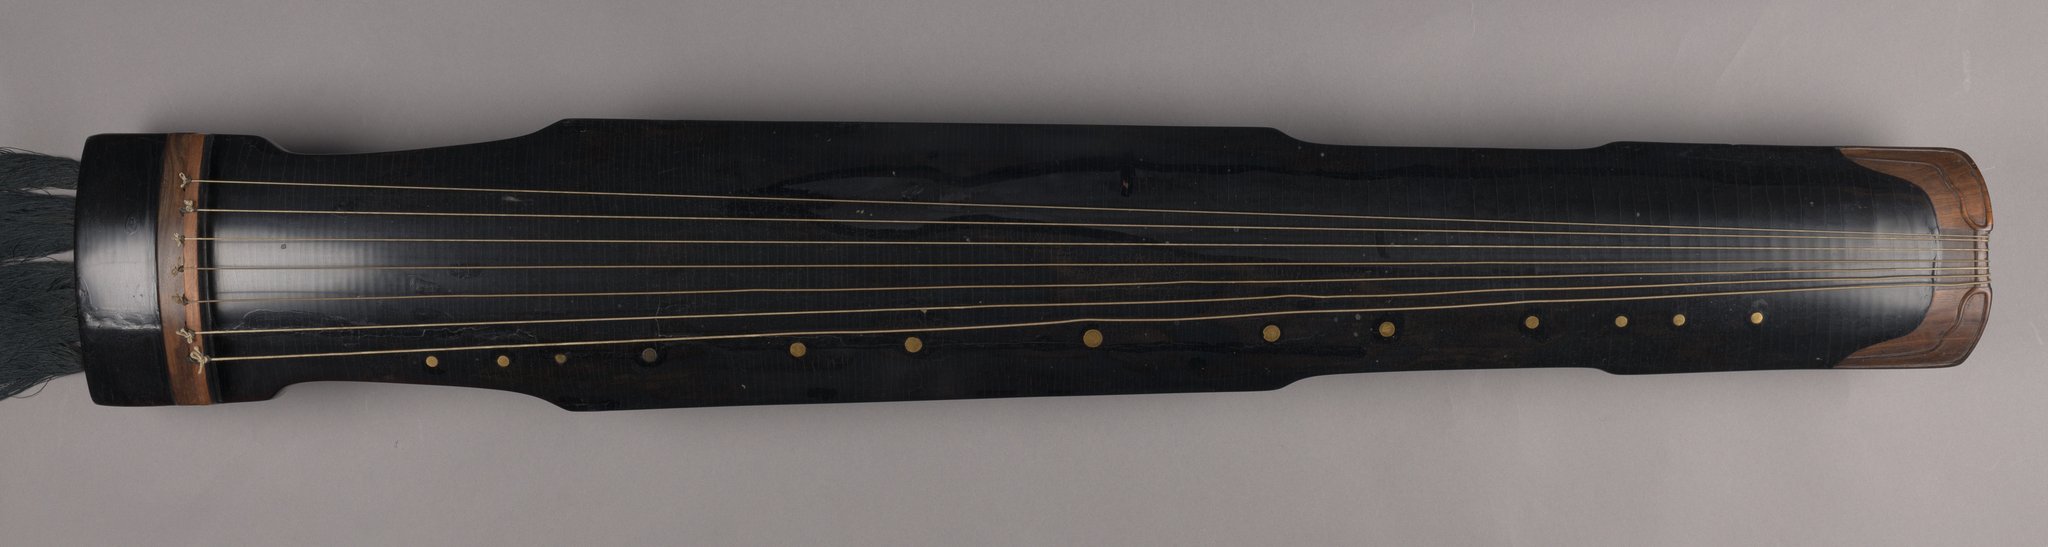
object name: qin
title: Qin (Seven-stringed zither)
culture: chinese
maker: unidentified artist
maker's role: artist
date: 1567-1600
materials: lacquer